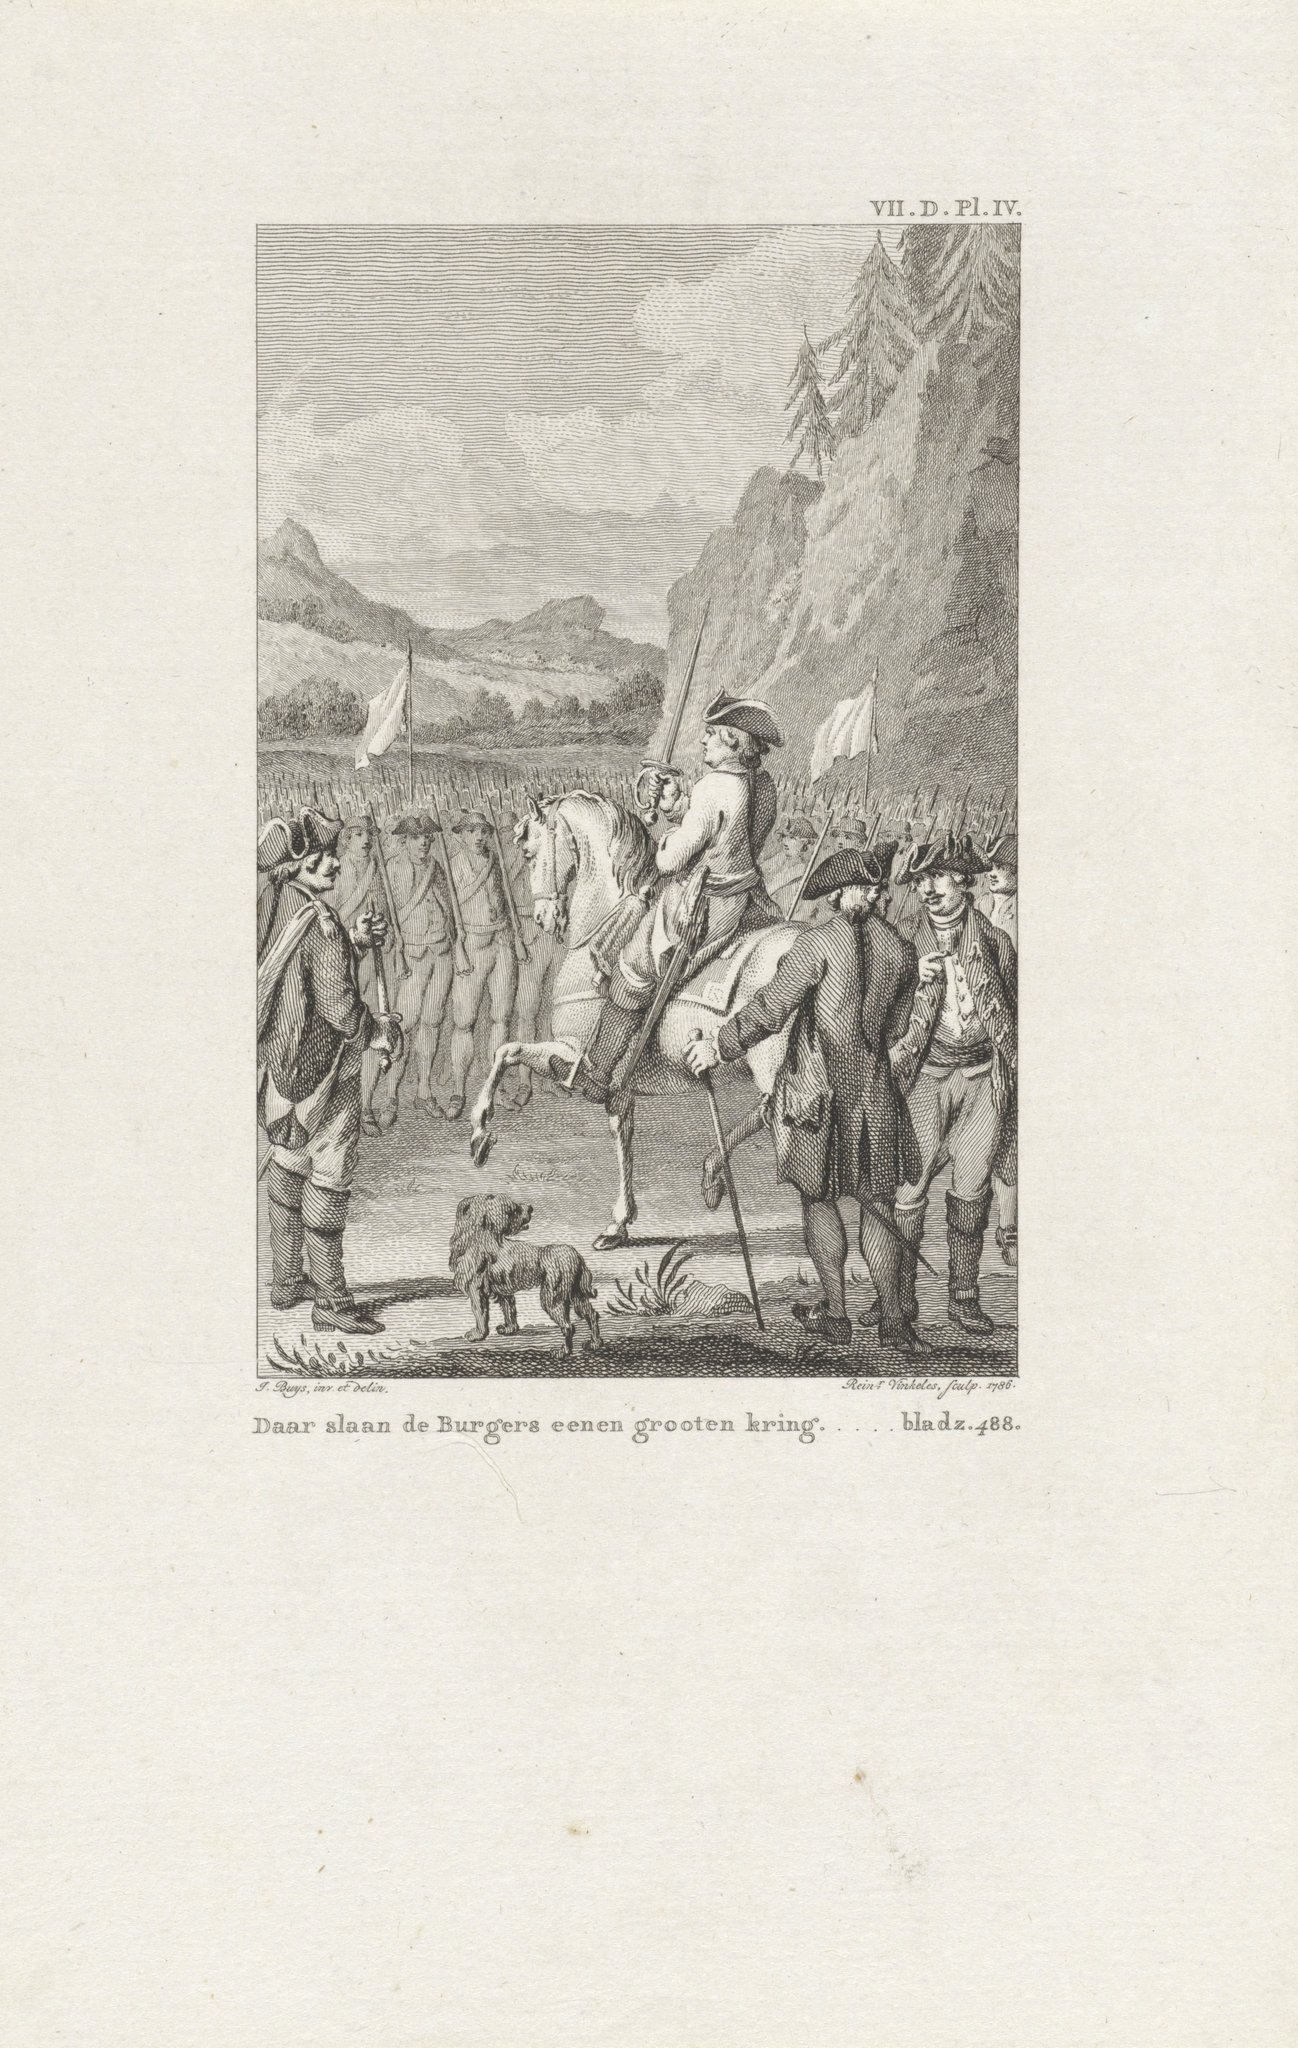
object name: print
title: Daar slaan de Burgers eenen grooten kring (...)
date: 1786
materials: paper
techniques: engraving, etching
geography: amsterdam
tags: meeting, assembly - aa - in the open air, switzerland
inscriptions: collector's mark: Lugt 240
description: Prent gebruikt als boekillustratie in: Martinet, Joannes Florentius. Historie der waereld. Amsterdam: Johannes Allart, 1780-1788. 25 delen. deel VII, pl. III.